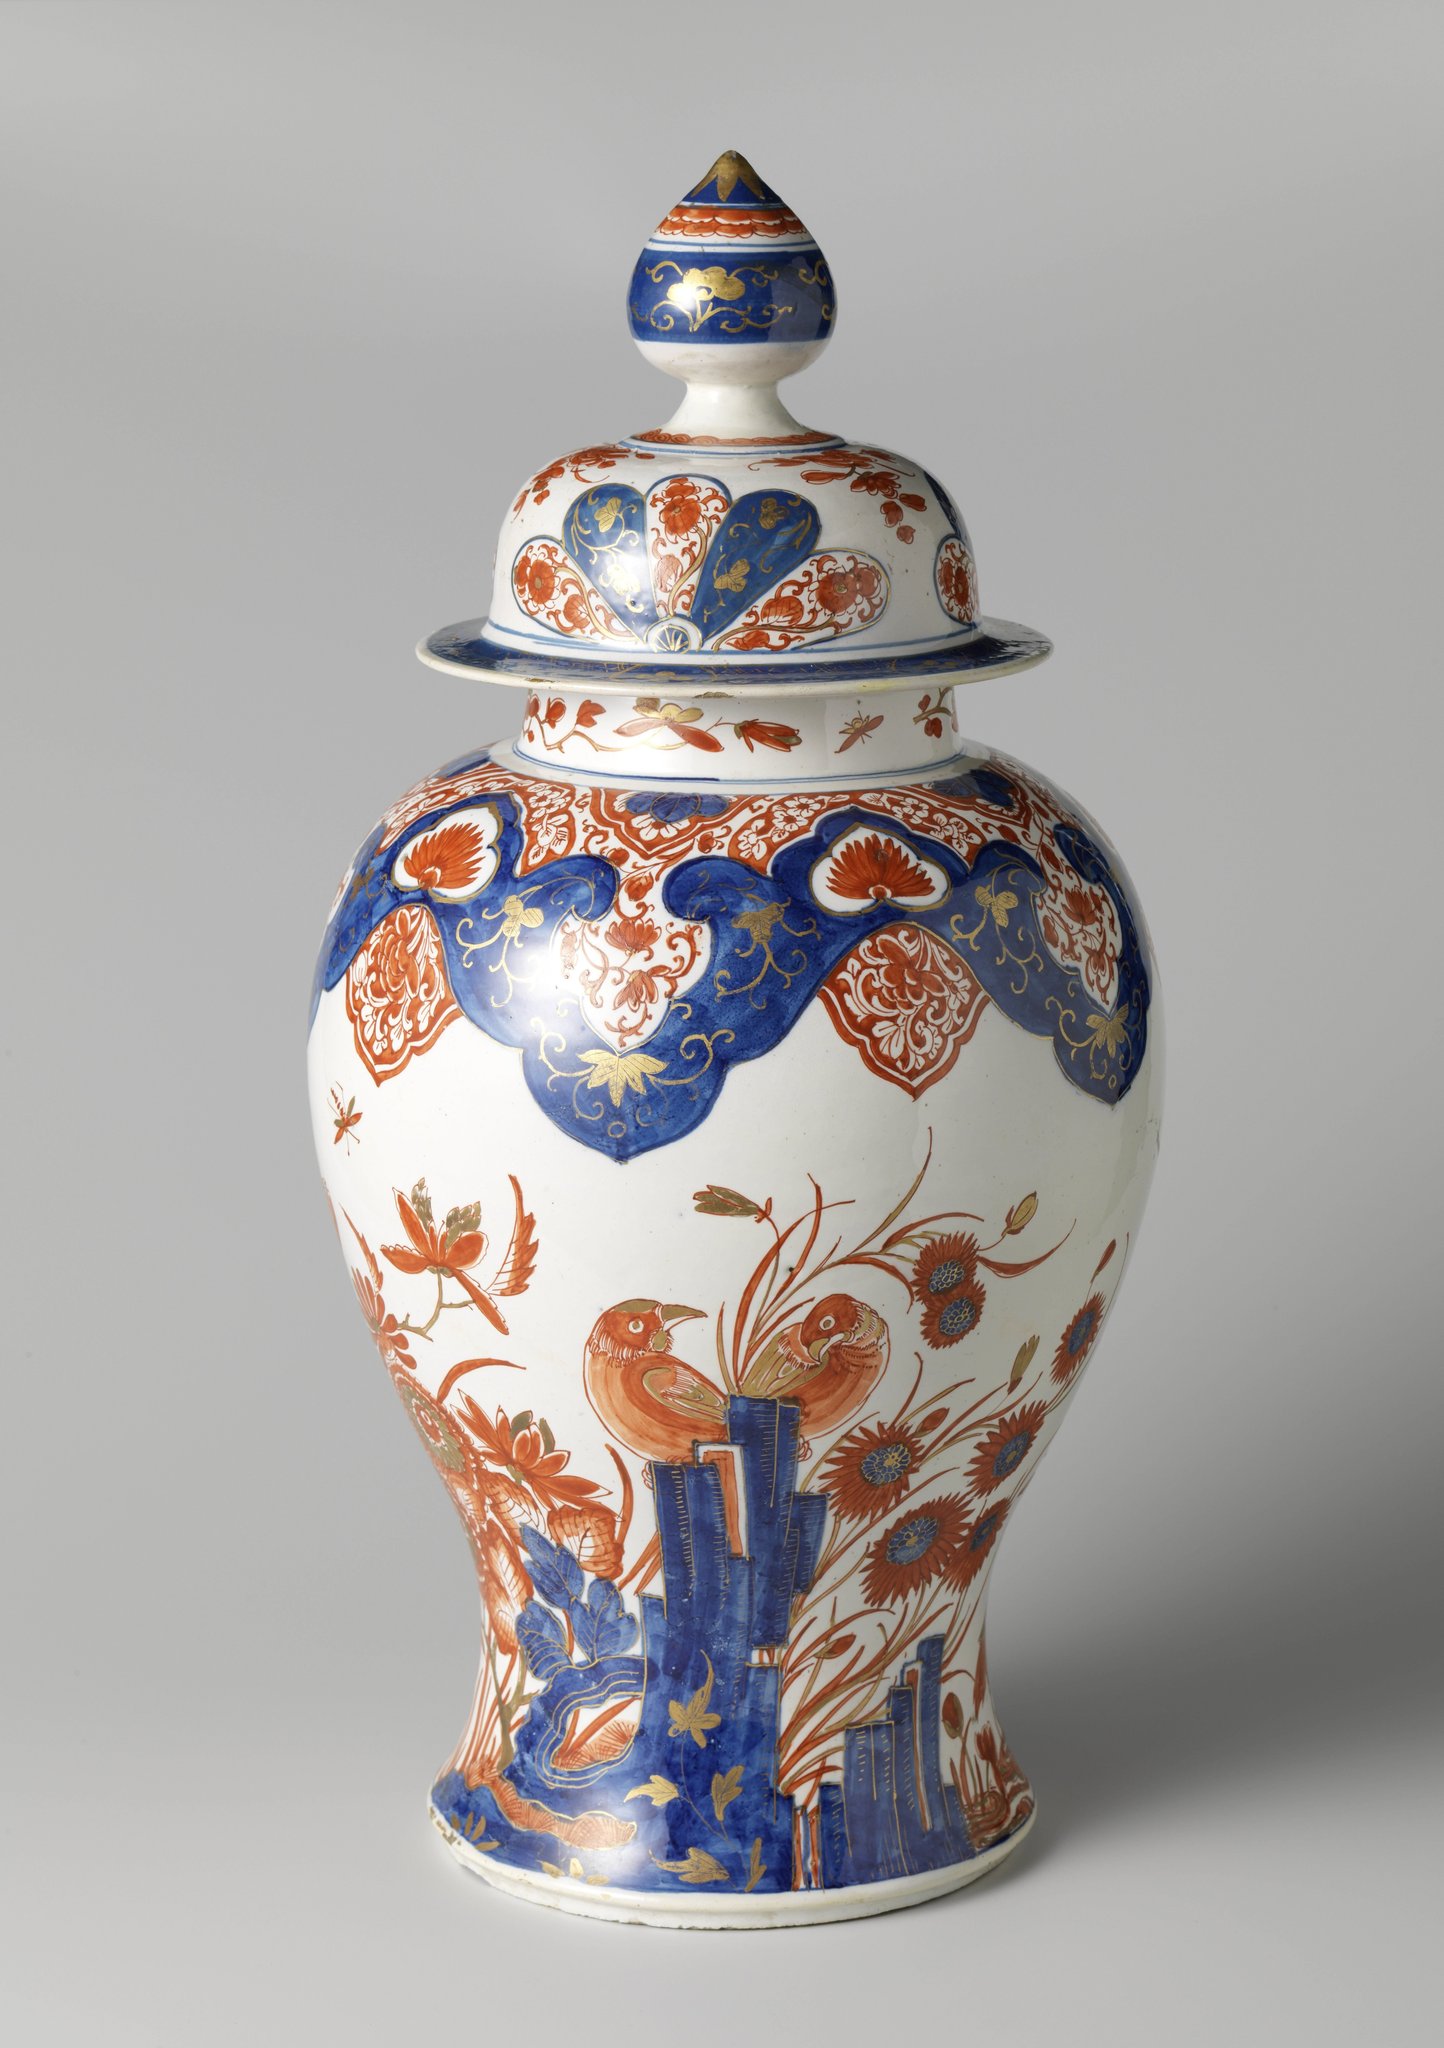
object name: pot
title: Lidded jar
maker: Anonymous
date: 1700-1715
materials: earthenware, glaze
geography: delft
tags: flowers ~ ornament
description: Pot van faïence. Veelkleurig beschilderd.